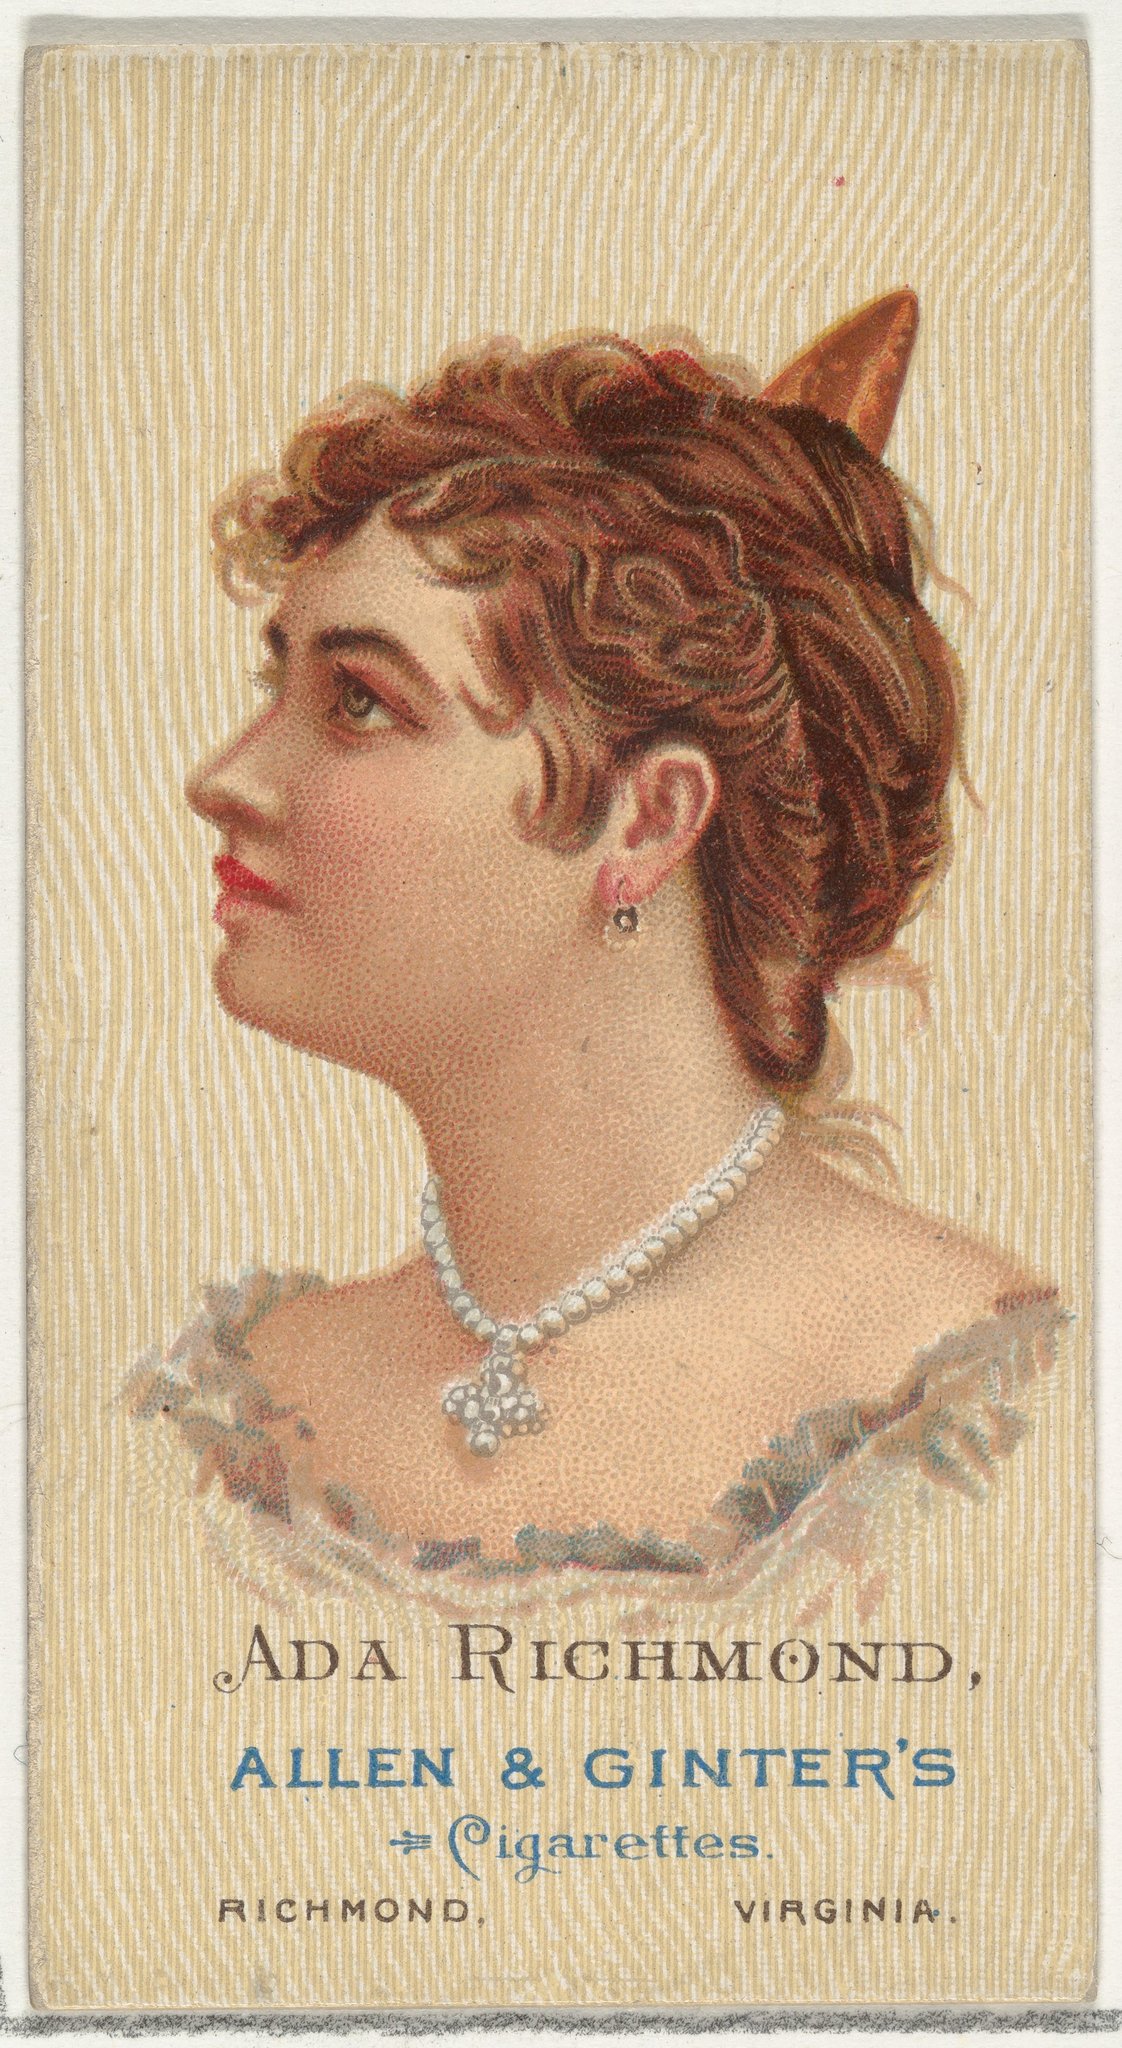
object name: print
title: Ada Richmond, from World's Beauties, Series 2 (N27) for Allen & Ginter Cigarettes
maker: allen & ginter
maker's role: publisher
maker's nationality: american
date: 1888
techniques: color lithograph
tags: women